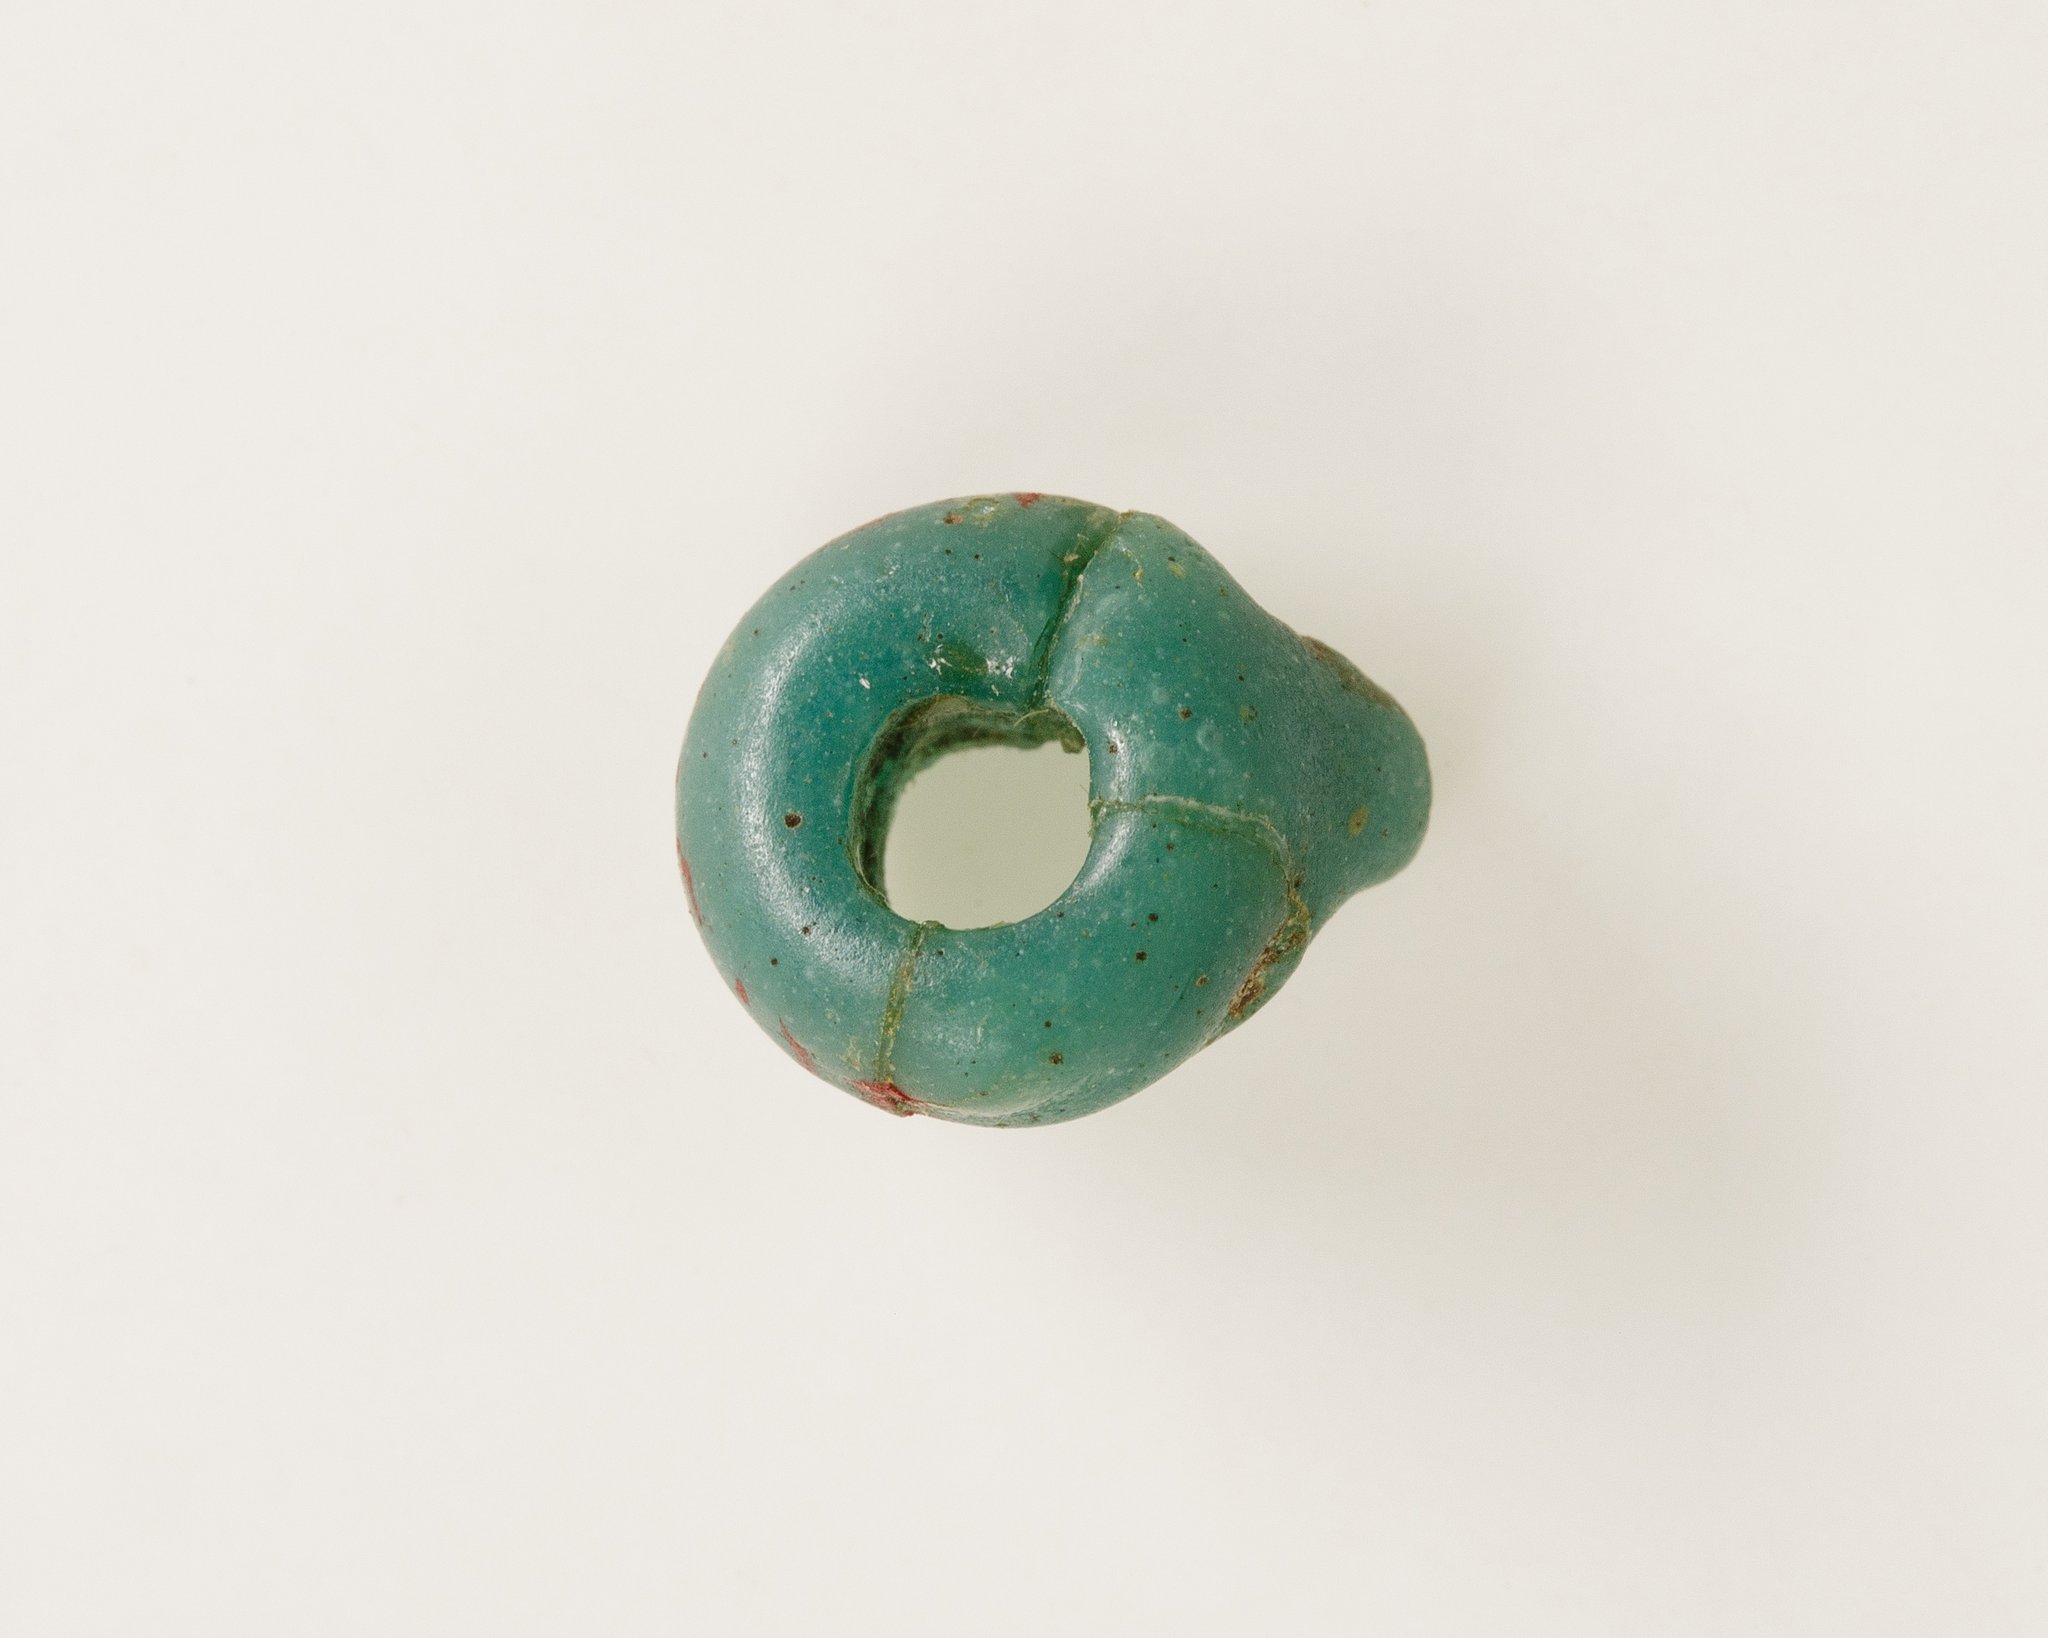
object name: bead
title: Ring Bead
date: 1070-343 BCE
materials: faience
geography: egypt